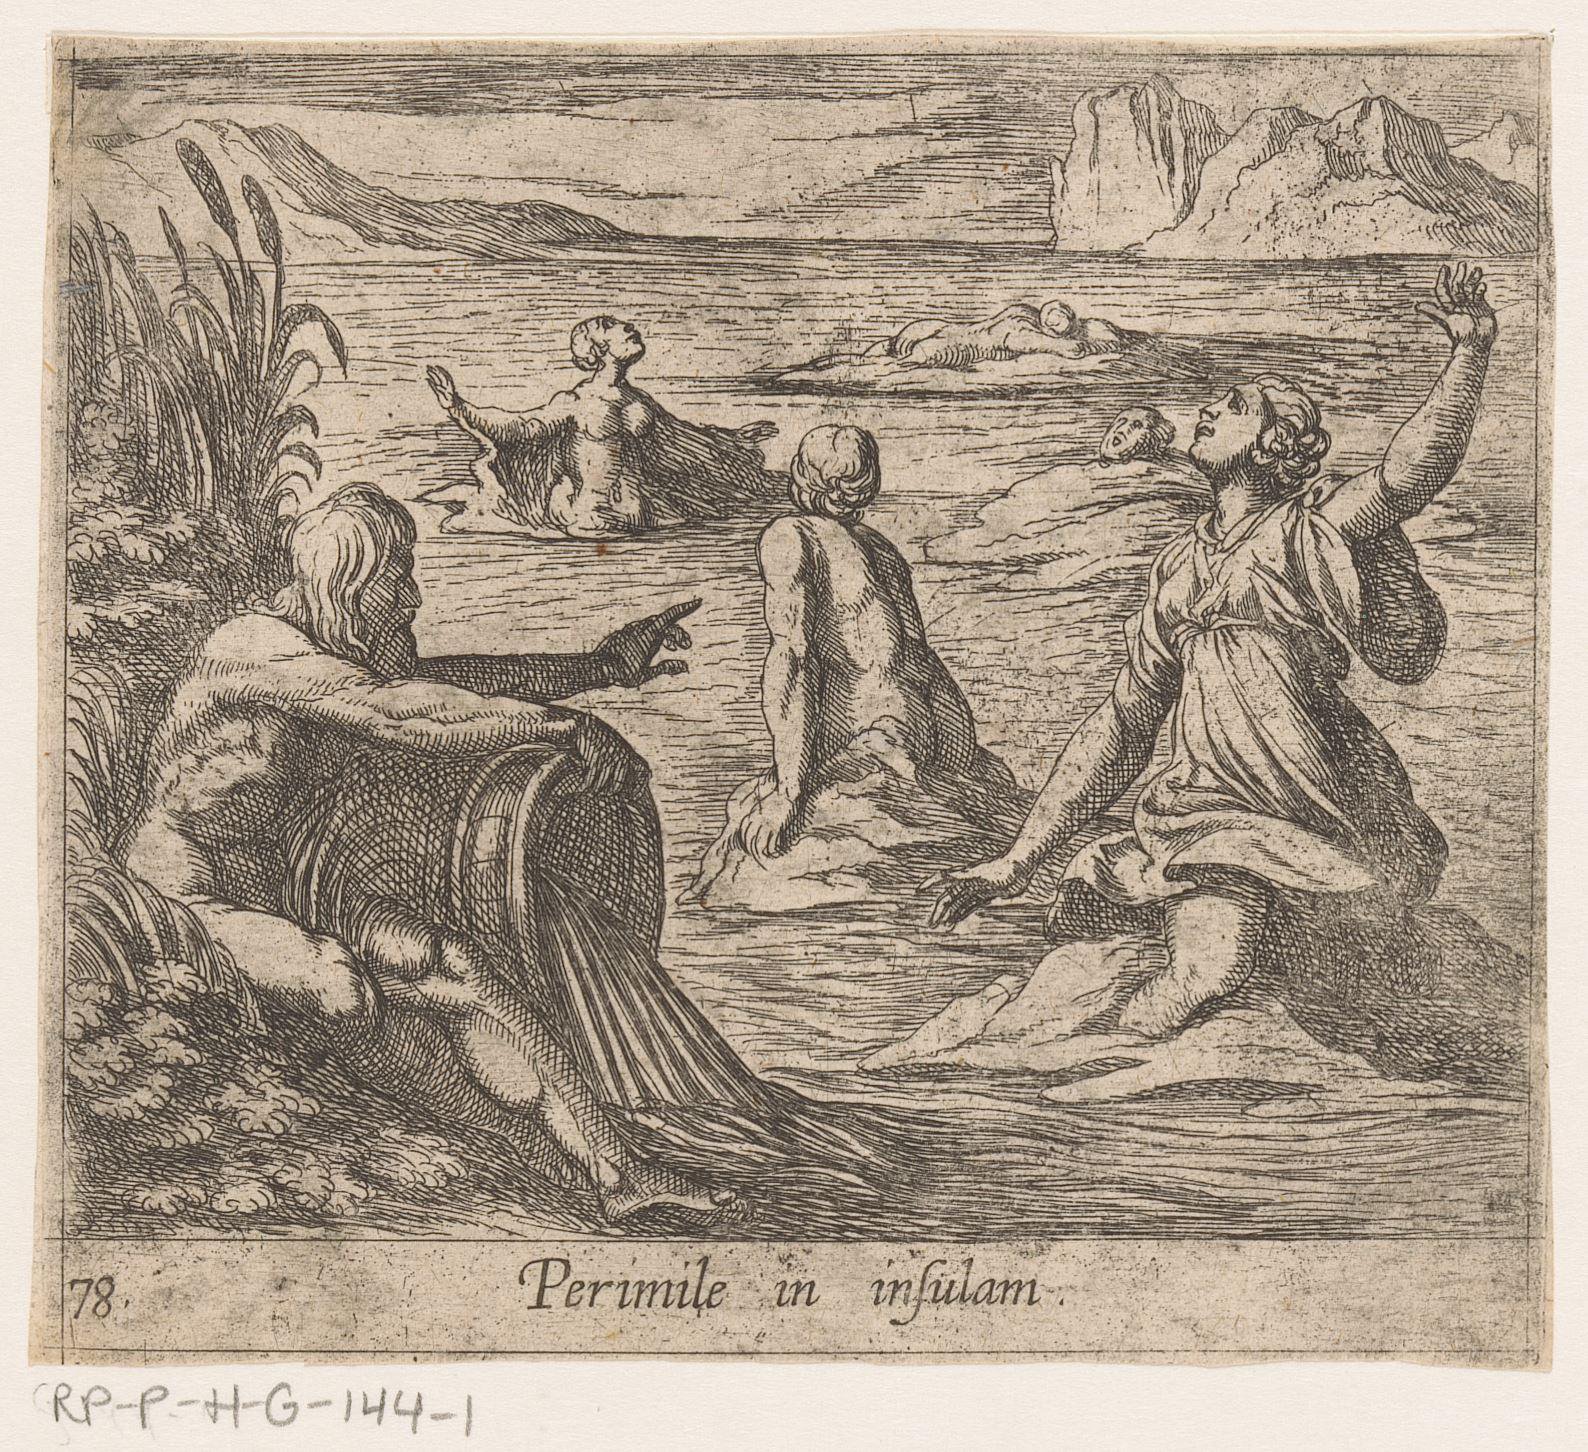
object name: print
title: Perimele in insulam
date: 1606-1638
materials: paper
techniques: etching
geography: italy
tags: perimele changed into an island: perimele, when thrown into the sea by her father hippodamas, is changed into an island by neptune, at achelous' request (ovid, metamorphoses viii 609)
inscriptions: collector's mark: ‘Hinloopen’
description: Perimele wordt in zee gegooid door haar vader Hippodamas en veranderd in een eiland door Neptunus. Op de voorgrond links een riviergod. Titel in het Latijn in ondermarge.